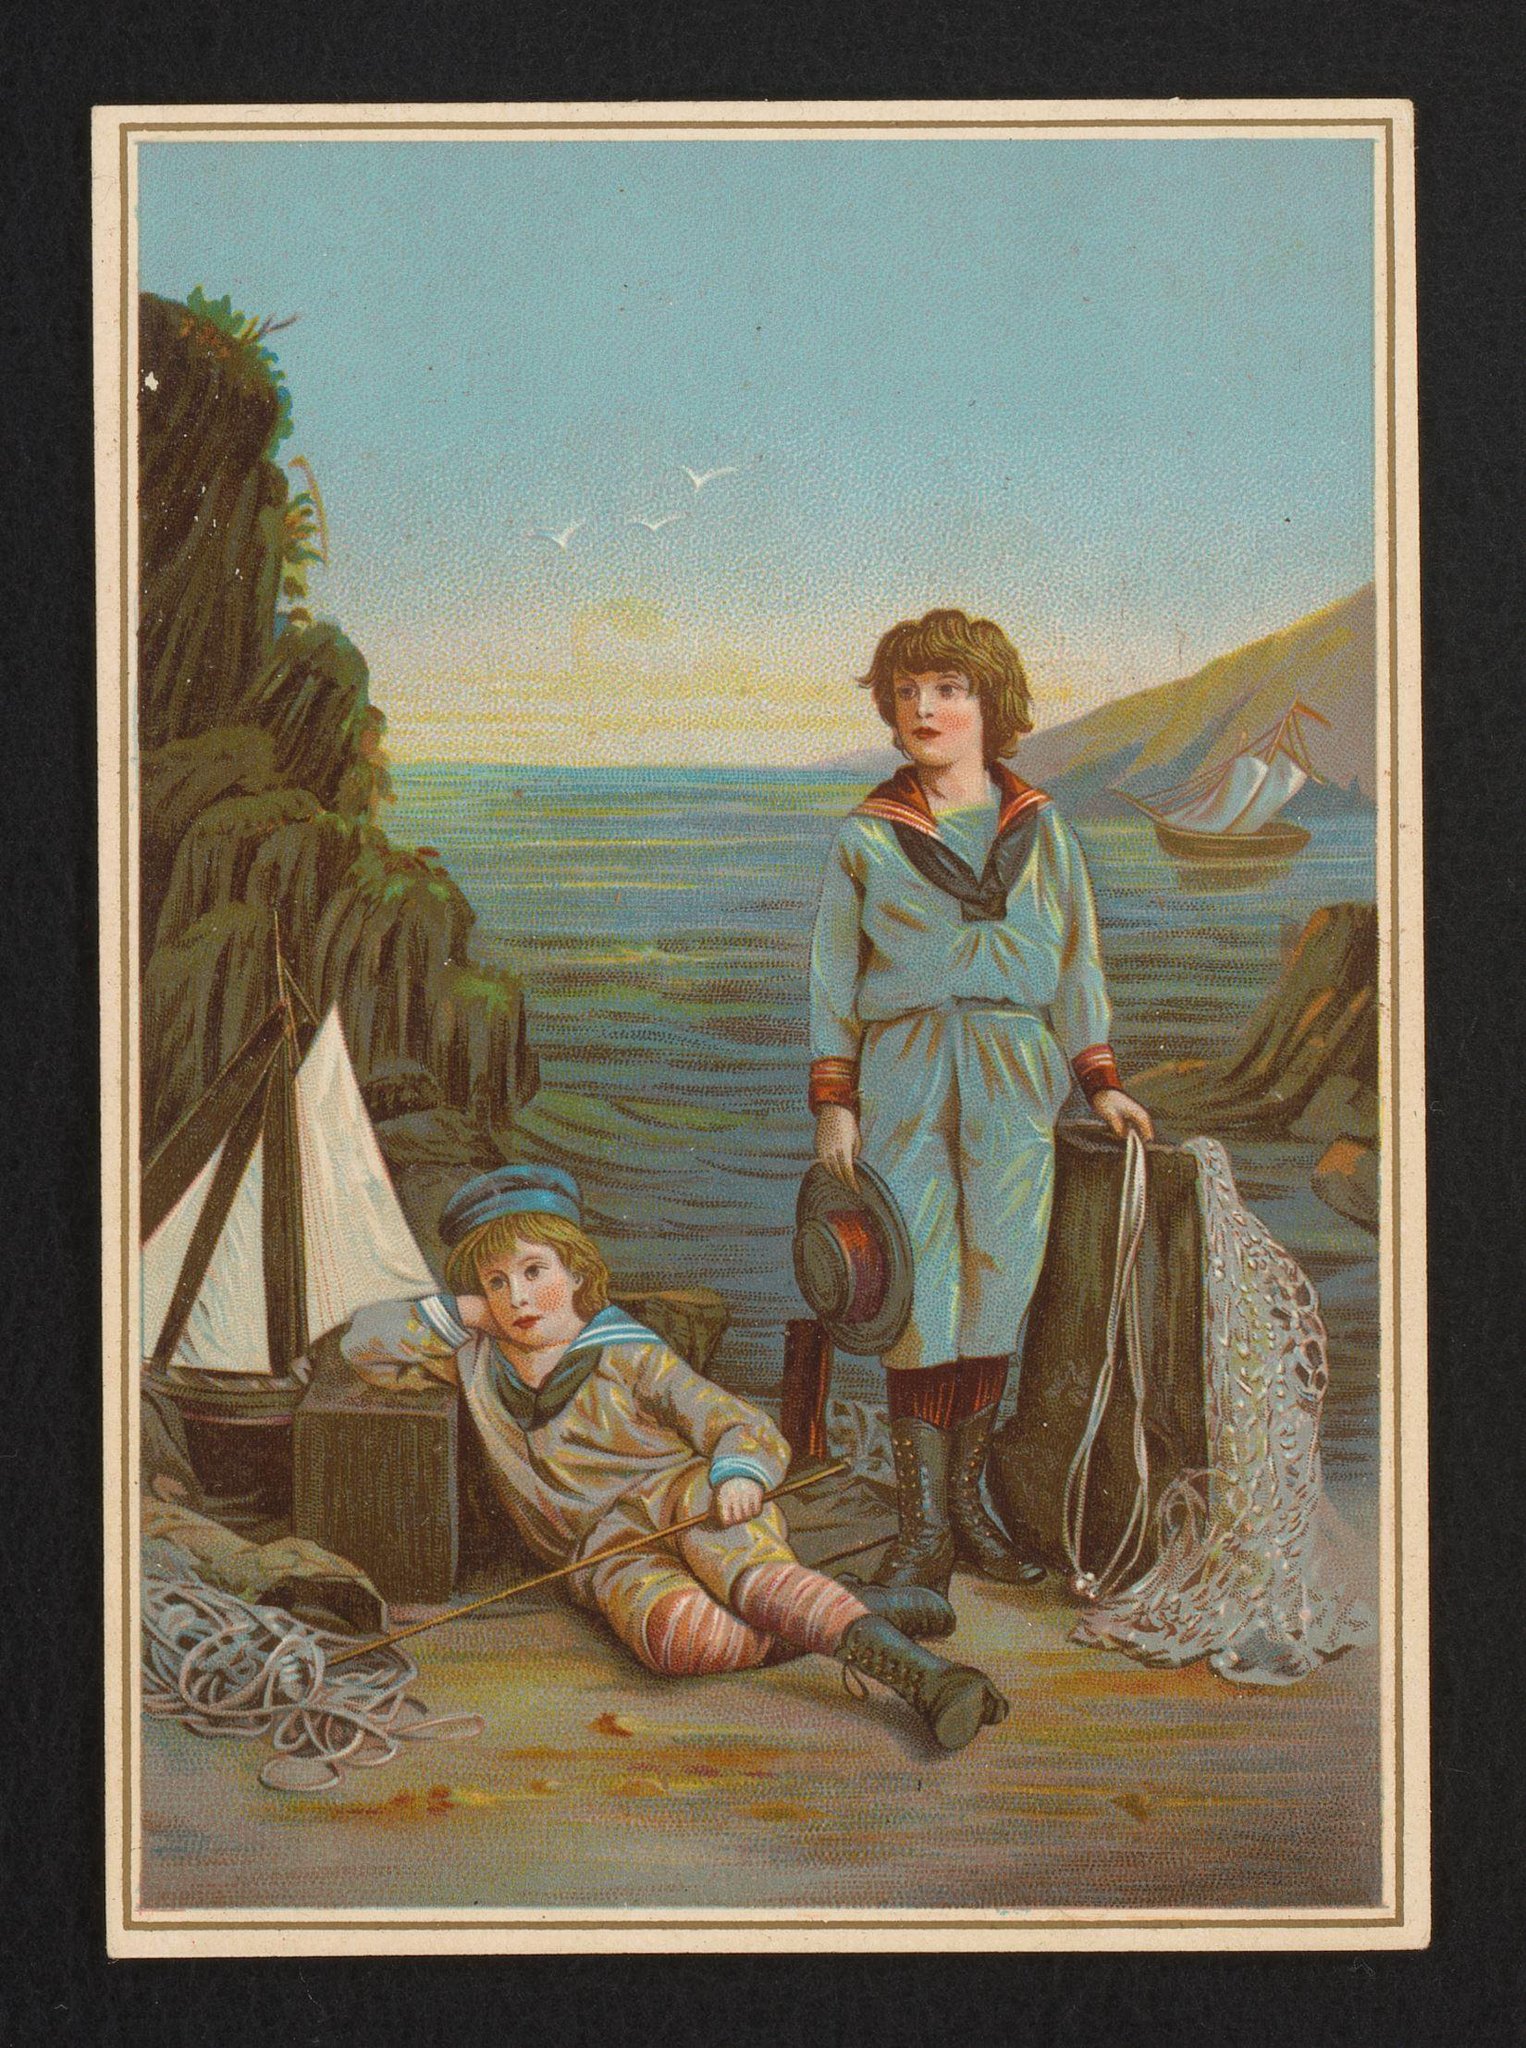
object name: print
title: Portret van twee jongens in matrozenpak op een kade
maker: Anonymous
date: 1880-1920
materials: cardboard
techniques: chromolithography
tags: ensemble of pieces of clothing: sailor suit, boy (child between toddler and youth) (+ two persons), historical persons, quay